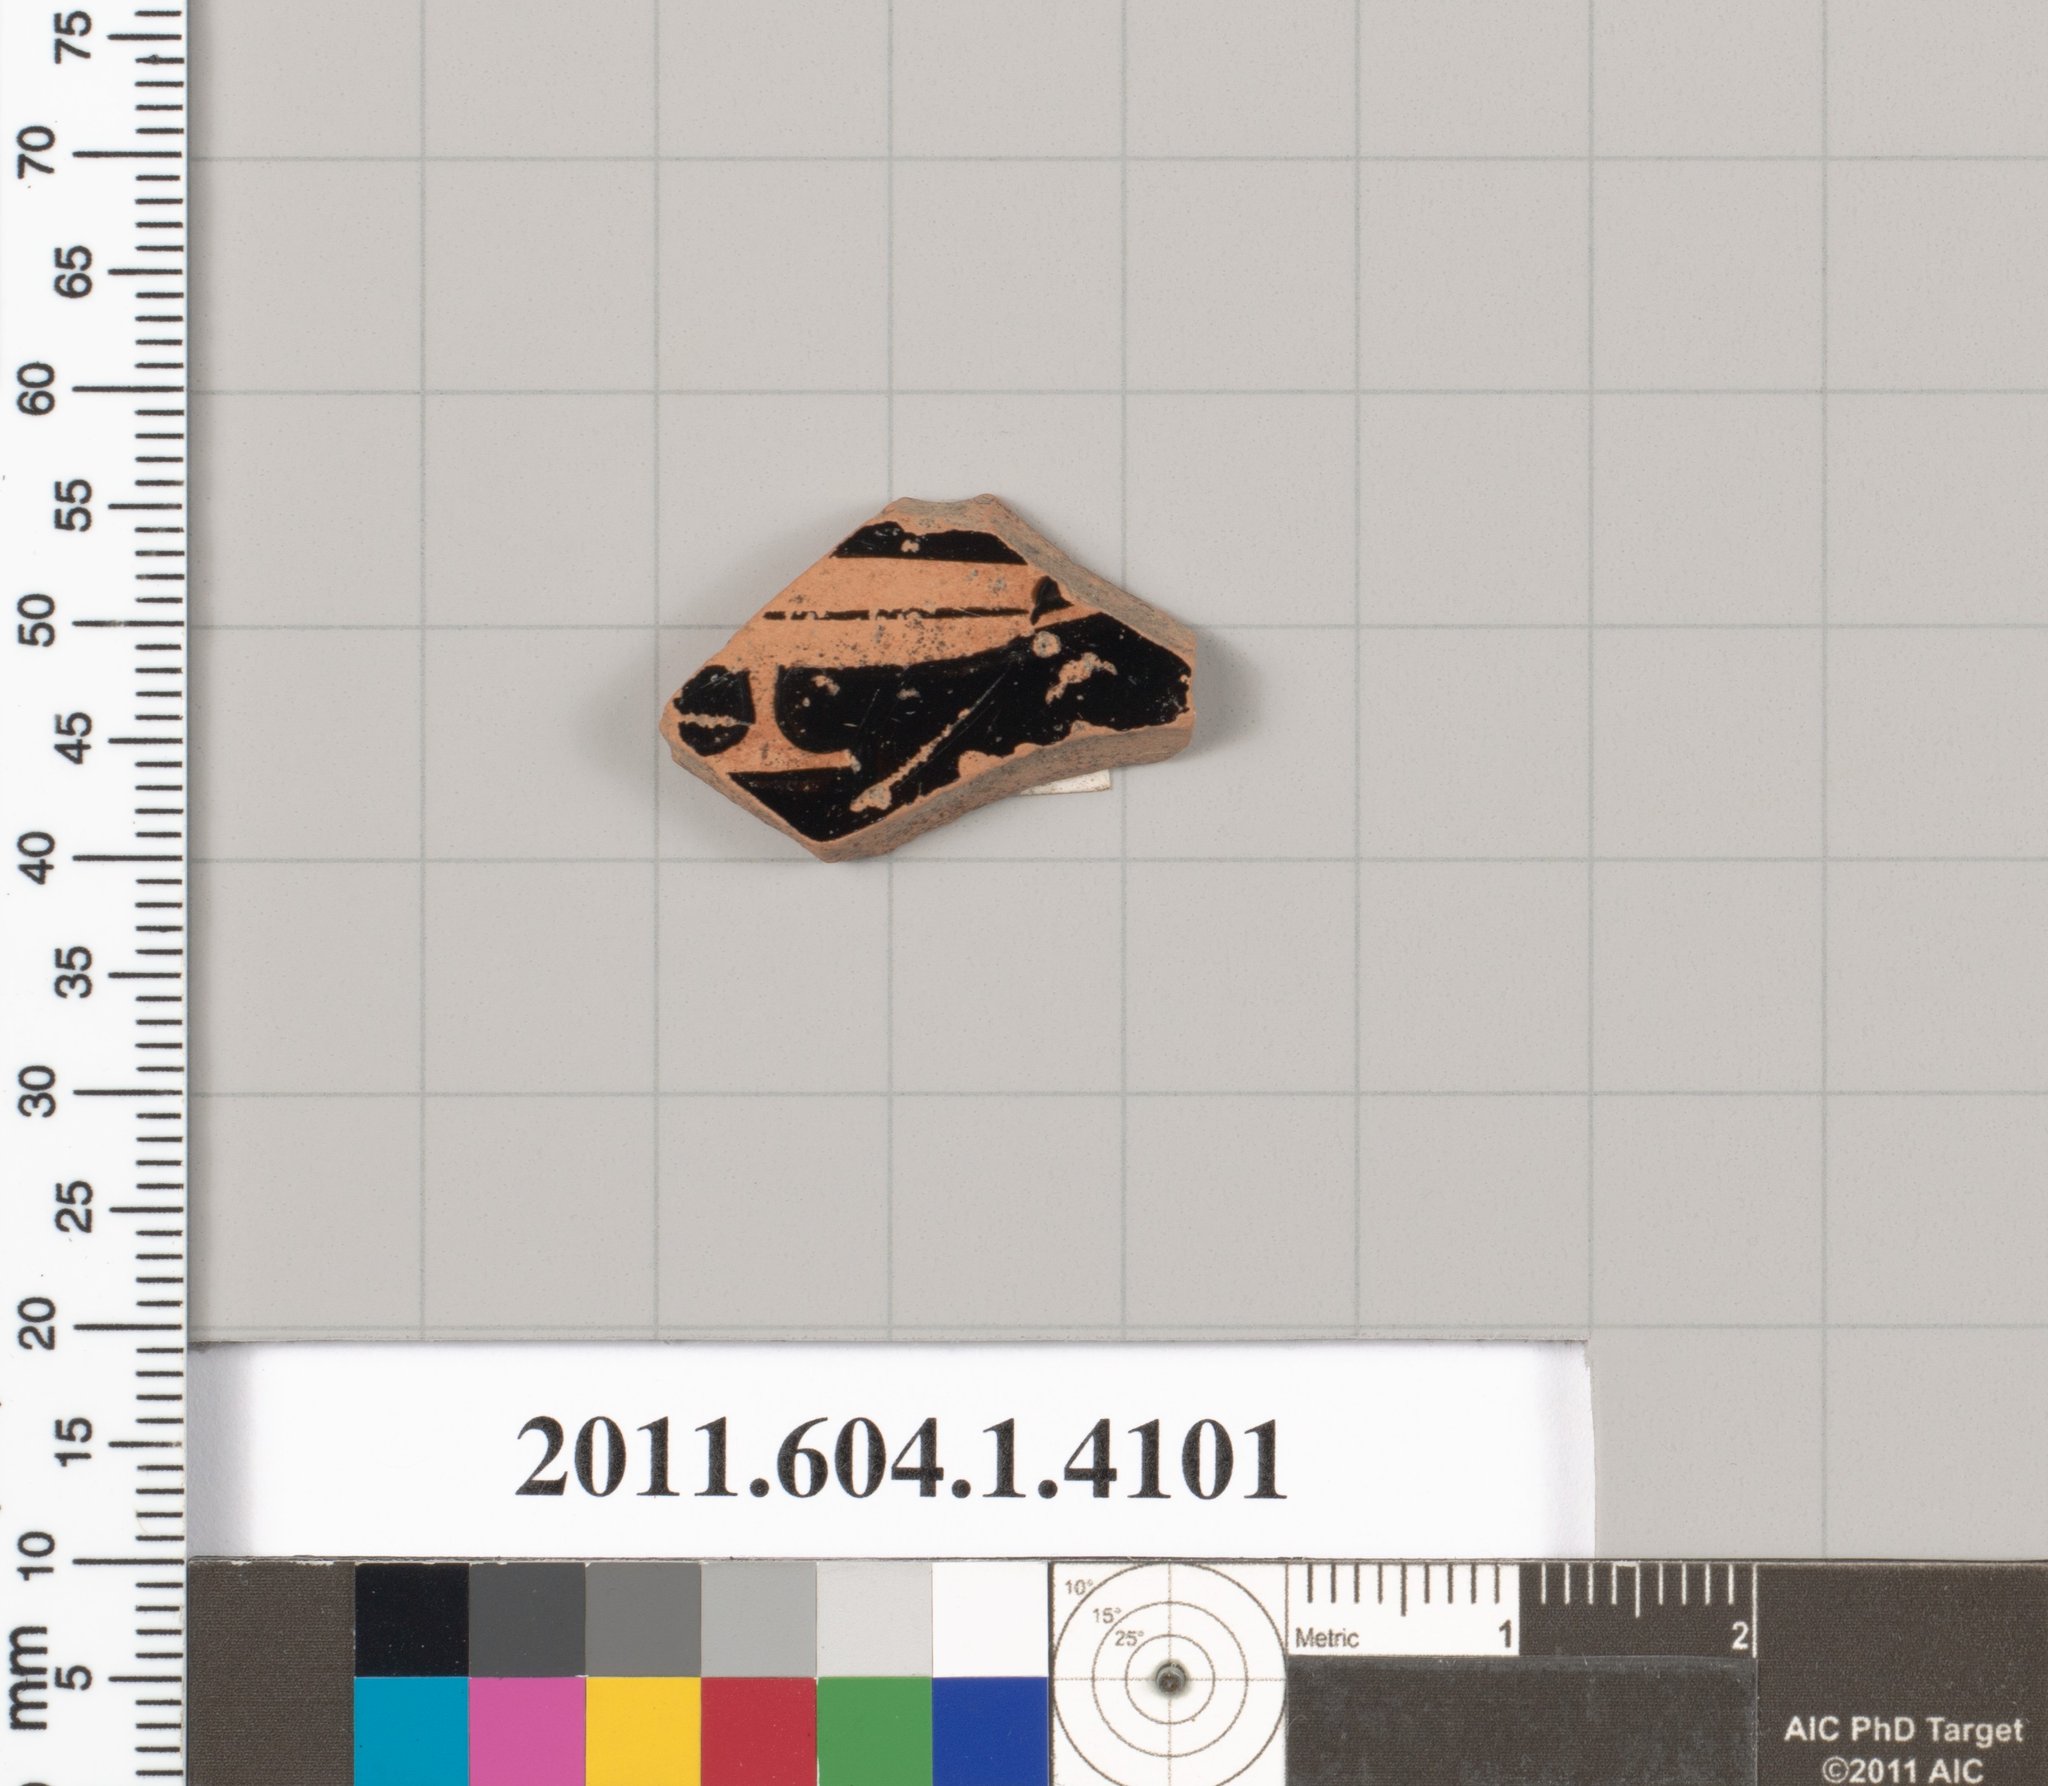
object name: kylix fragment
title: Terracotta fragment of a kylix (drinking cup)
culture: greek, attic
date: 510-490 BCE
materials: terracotta